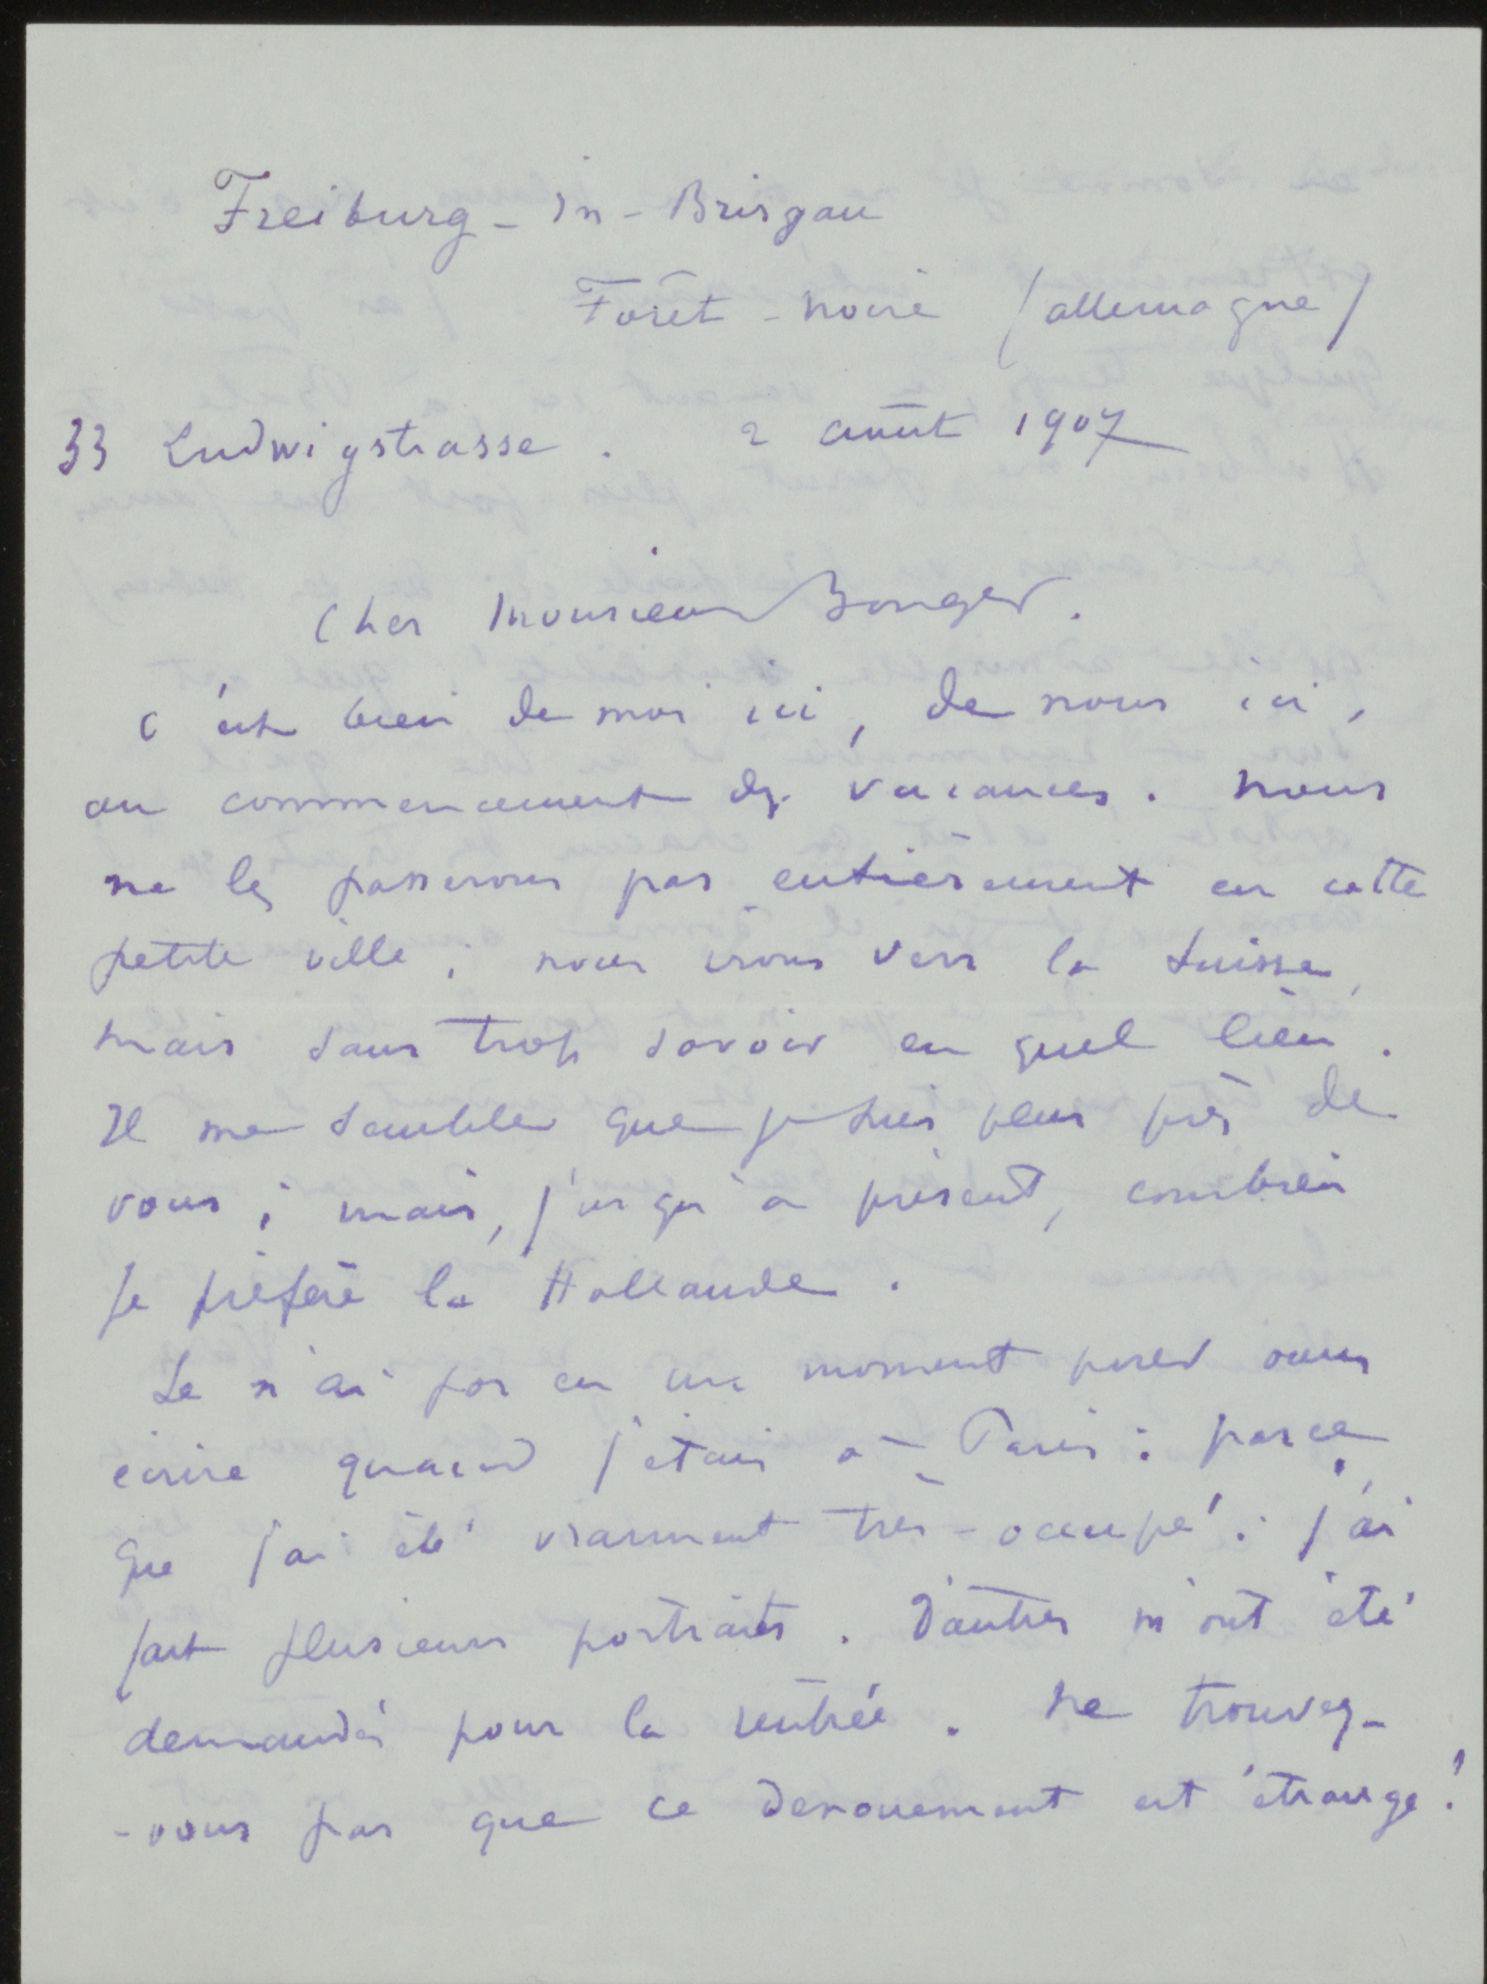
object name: letter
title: Brief aan Andries Bonger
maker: odilon redon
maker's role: draughtsman, painter, print maker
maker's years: 1840-1916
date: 1907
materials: ink, paper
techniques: pen, writing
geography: freiburg im breisgau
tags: camille redon-falte, arï redon, augsburg, london, hans holbein (ii), leiden, rembrandt van rijn, amsterdam, andries bonger, drawing, tennis, lawn-tennis, family life, travelling; tourism, painting (including book-illumination, miniature-painting), exhibition ~ art, historical persons (portraits and scenes from the life), netherlands, france, paris, switzerland